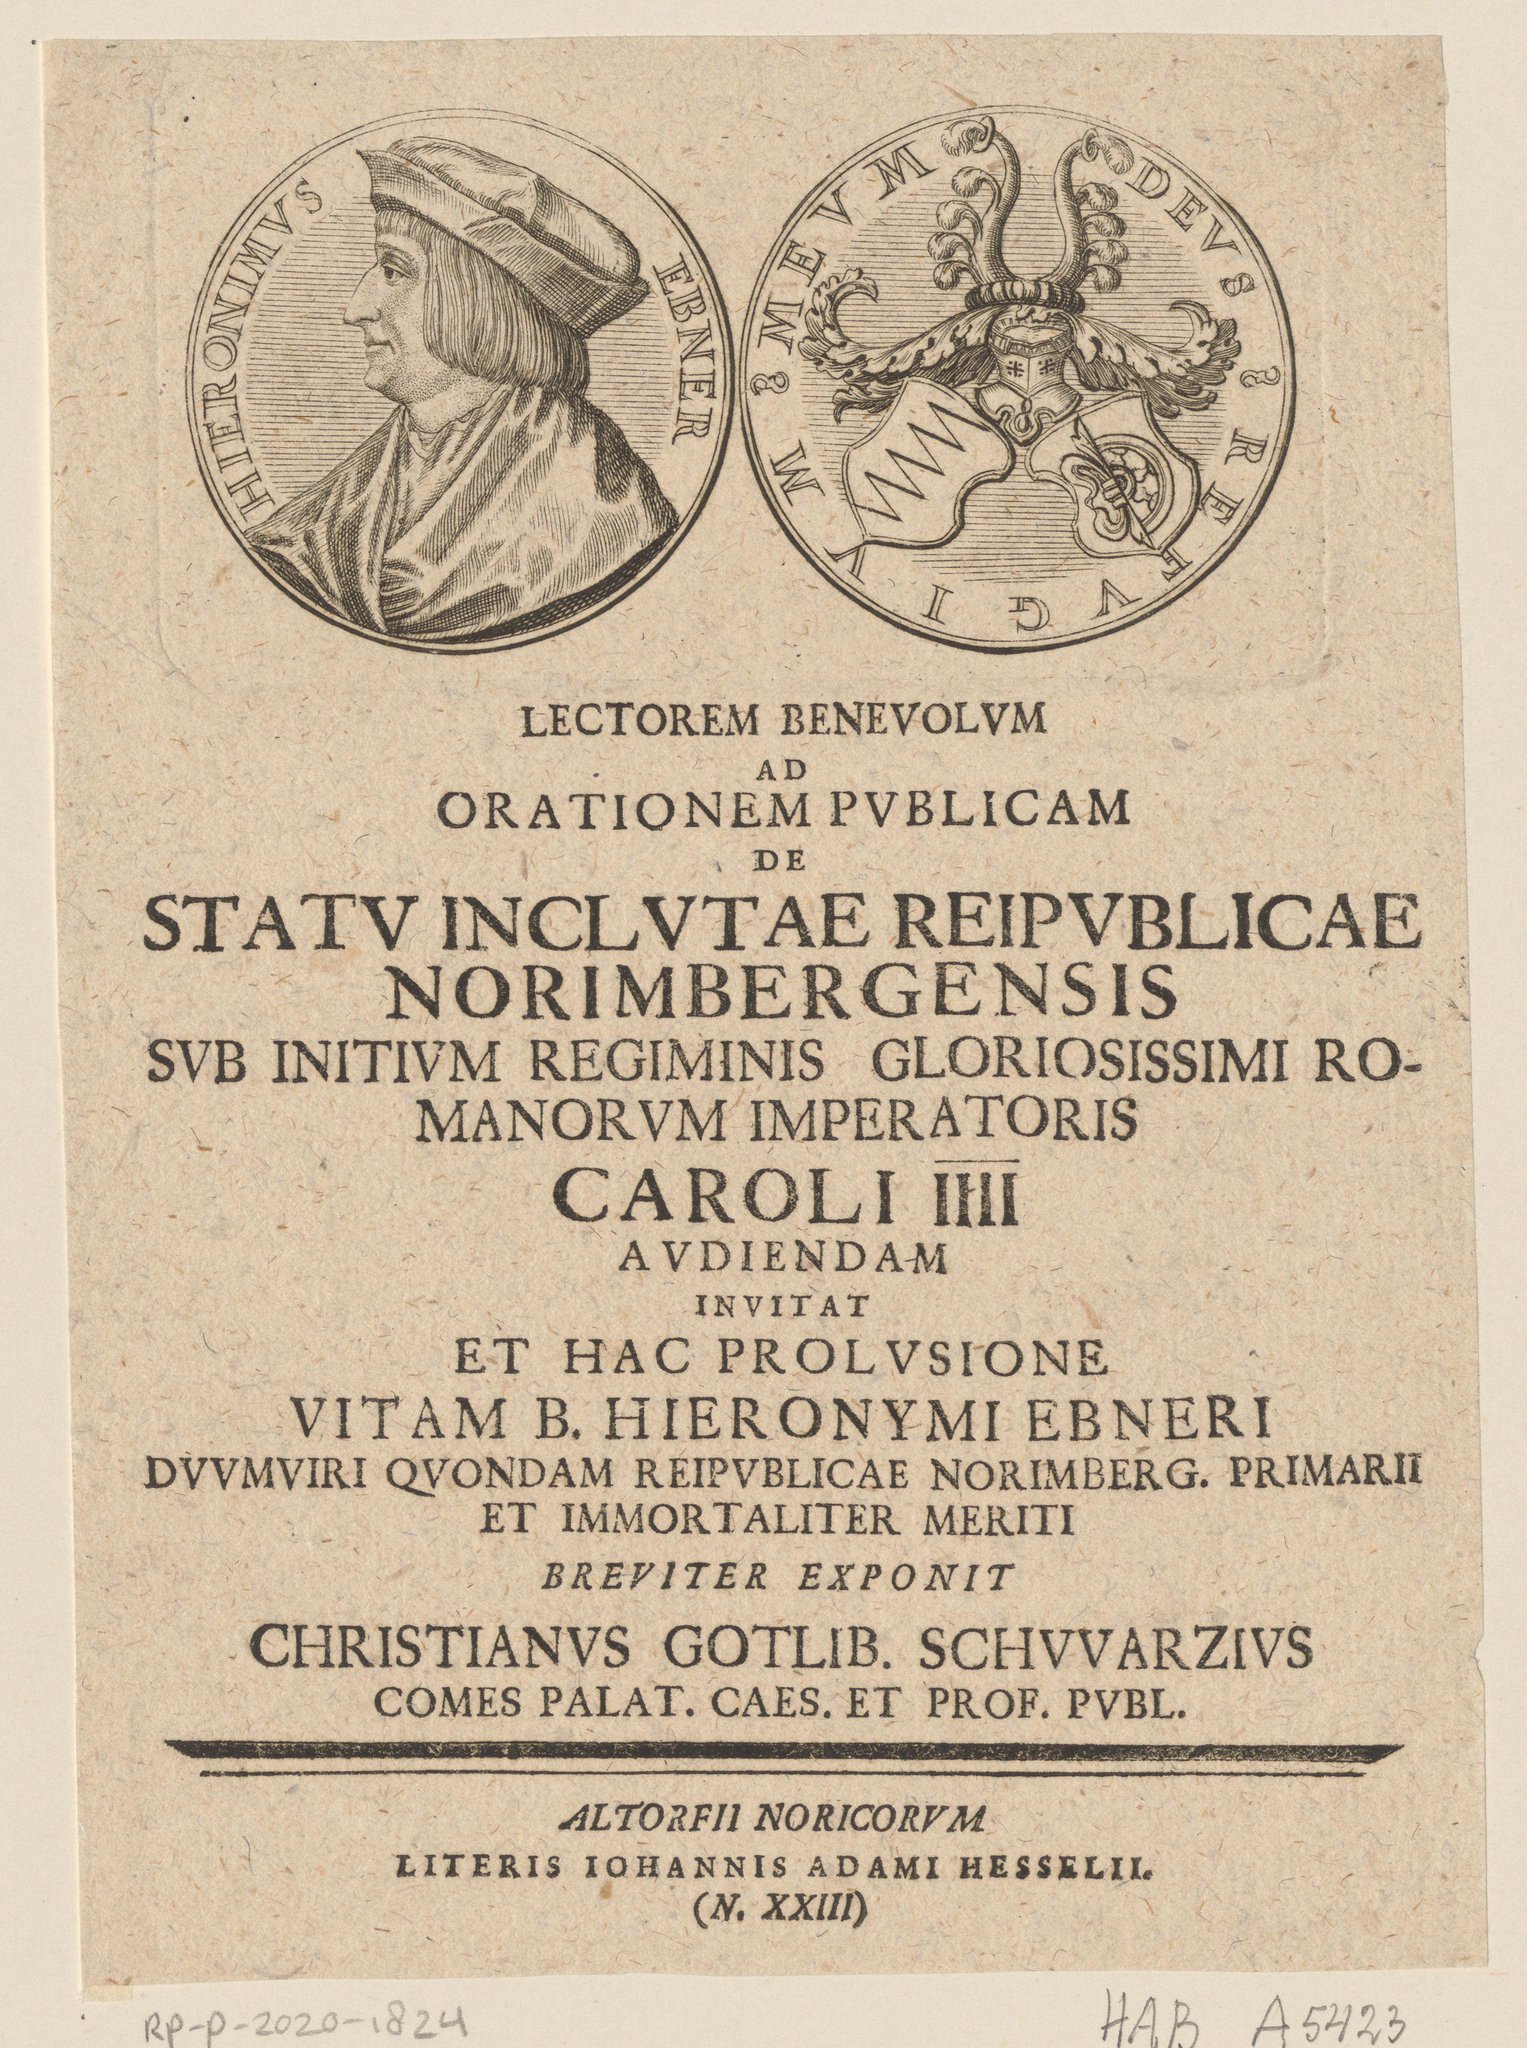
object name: titelblad, titelpagina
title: Twee munten met portret van Hieronymus Ebner en wapenschild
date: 1740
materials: paper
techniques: etching, letterpress printing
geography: germany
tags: historical persons, coin, armorial bearing, heraldry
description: Titelpagina voor: Schwarz, Christian Gottlieb. Lectorem Benevolum Ad Orationem Publicam De Statu Inclutae Reipublicae Norimbergensis (...). Neurenberg: Johann Adam Hessel, 1740.